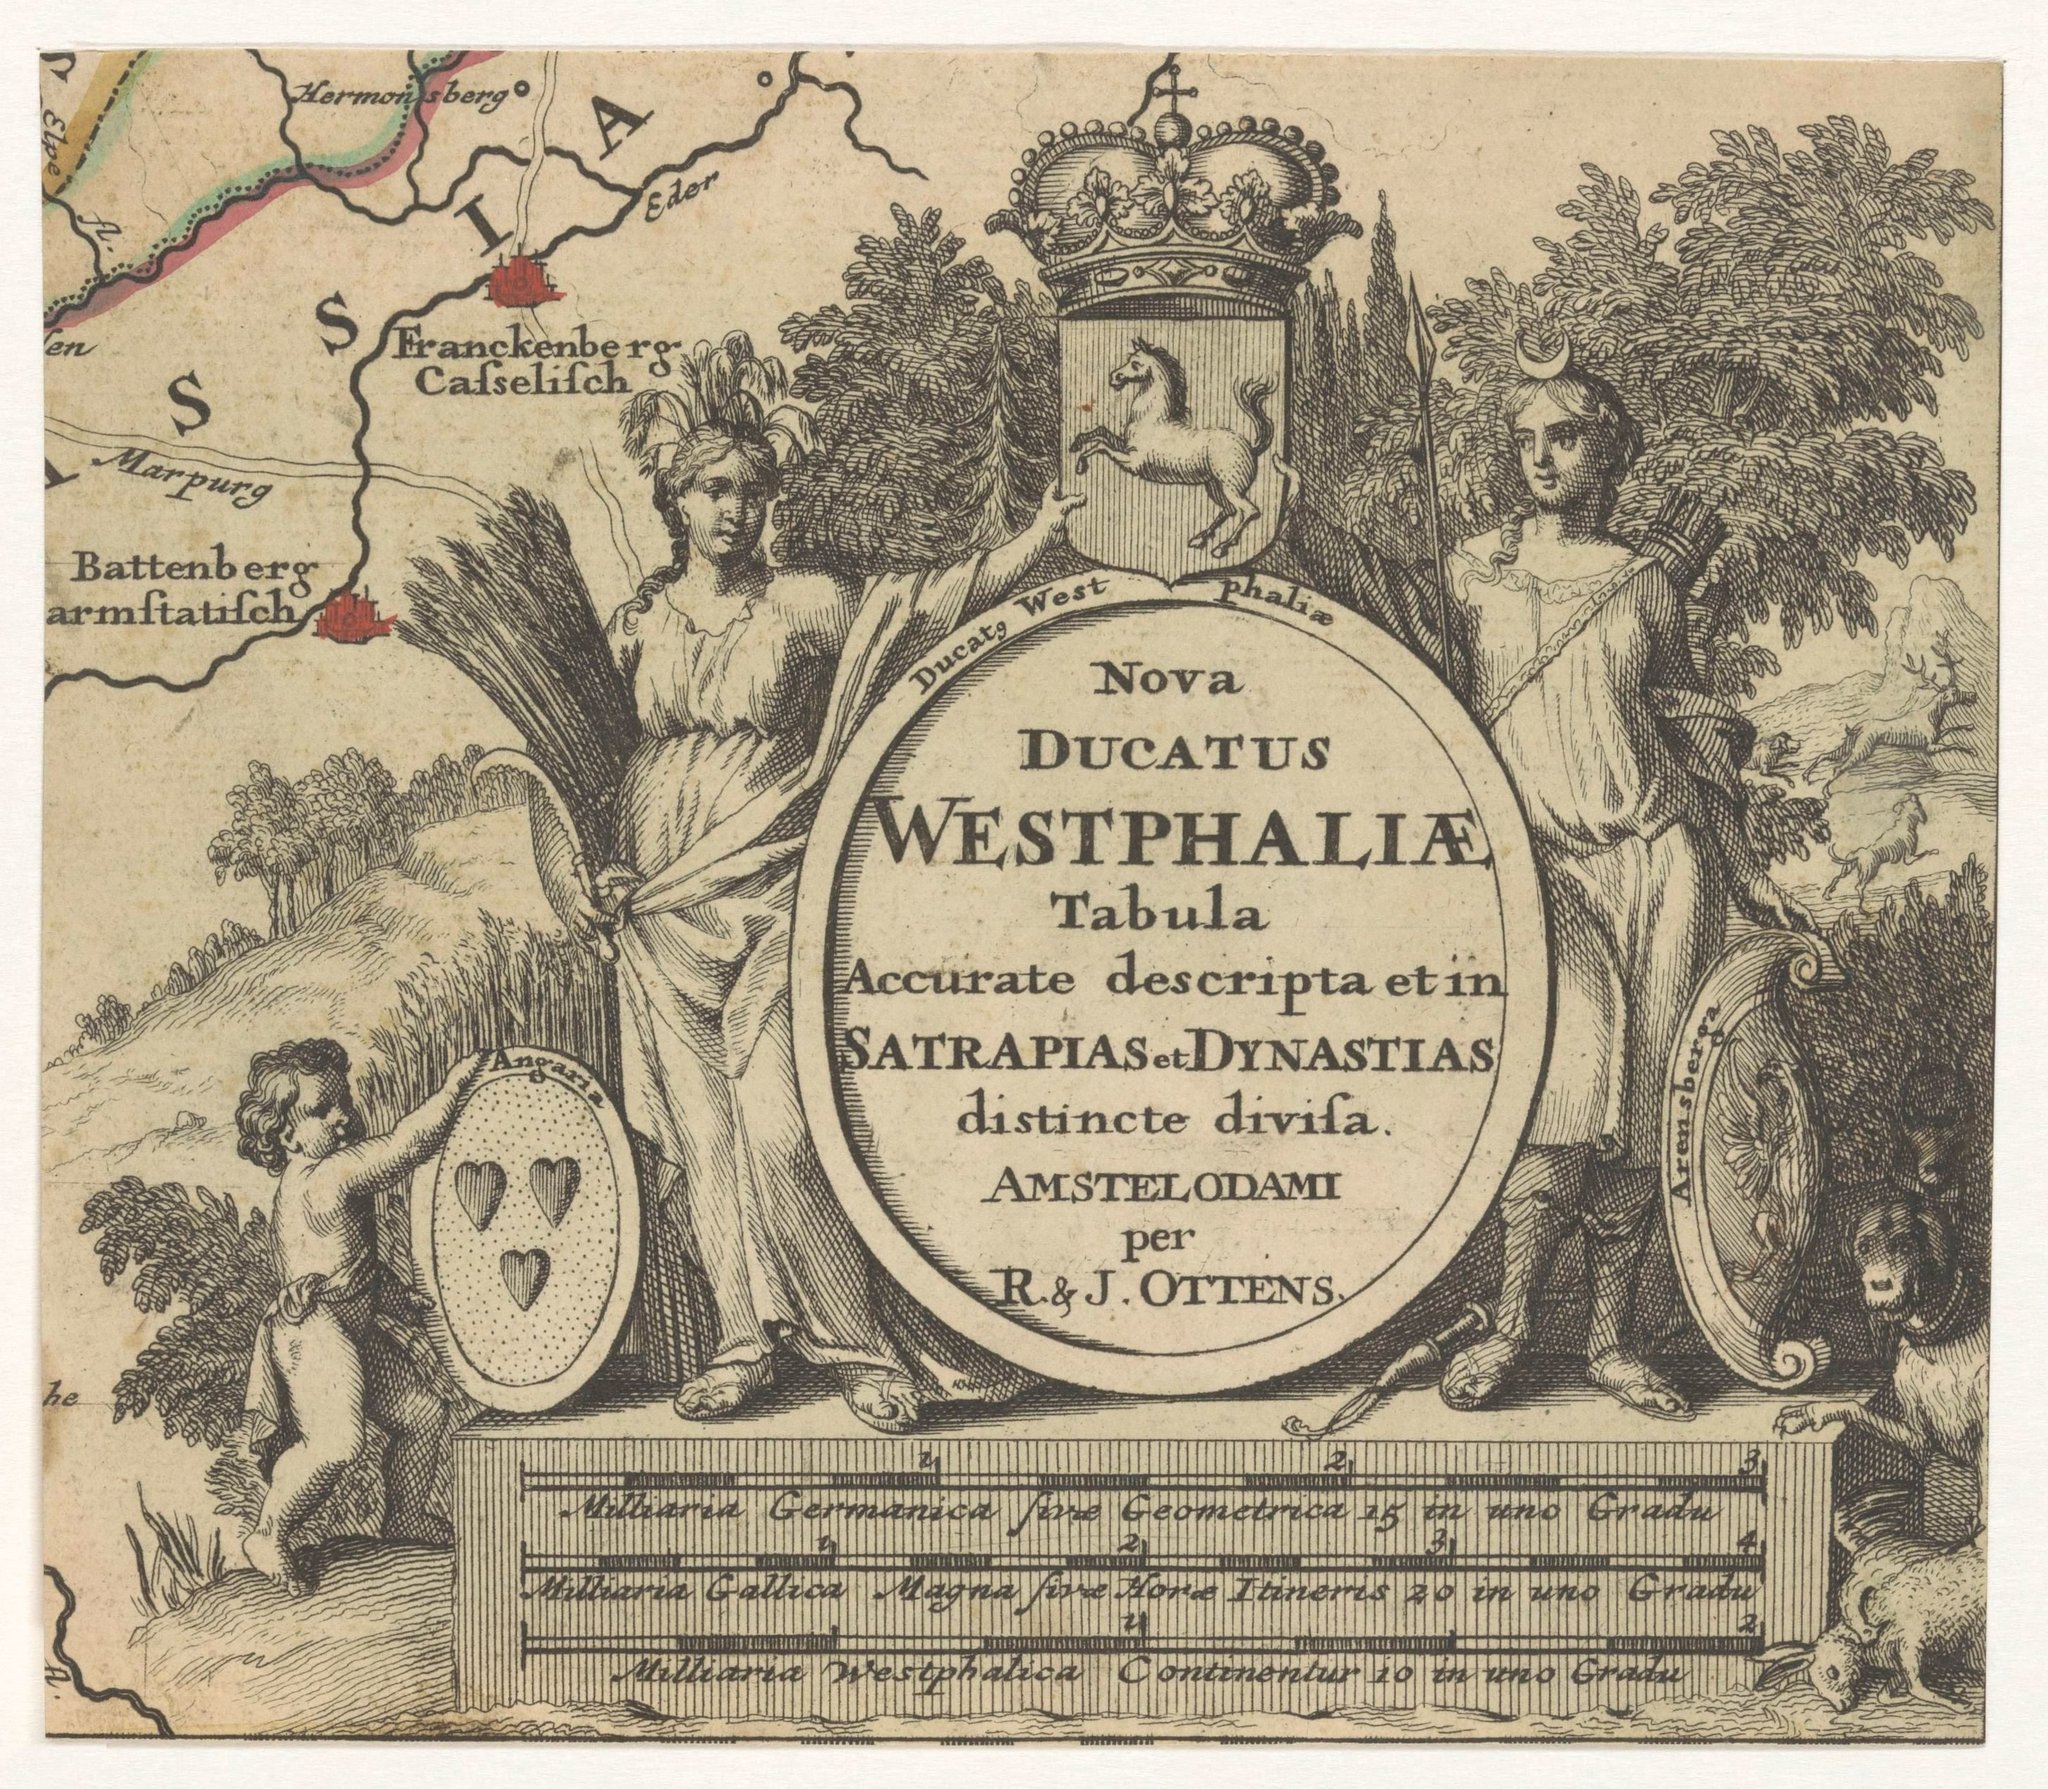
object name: print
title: Nova Ducatus Westphaliae (...)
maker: Anonymous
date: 1720-1730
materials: paper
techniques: etching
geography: amsterdam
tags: (story of) ceres (demeter), (story of) diana (artemis), ornament ~ medallion, westphalia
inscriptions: collector's mark: Lugt 2228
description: Ceres met korenschoof en sikkel en Diana met halve maan op het hoofd en jachtattributen flankeren een medaillons met titel. Daarboven houden zij het gekroond wapenschild van Westfalen. Links staat een putto met schild drie harten. Detail van een kaart van Westfalen in Duitsland.